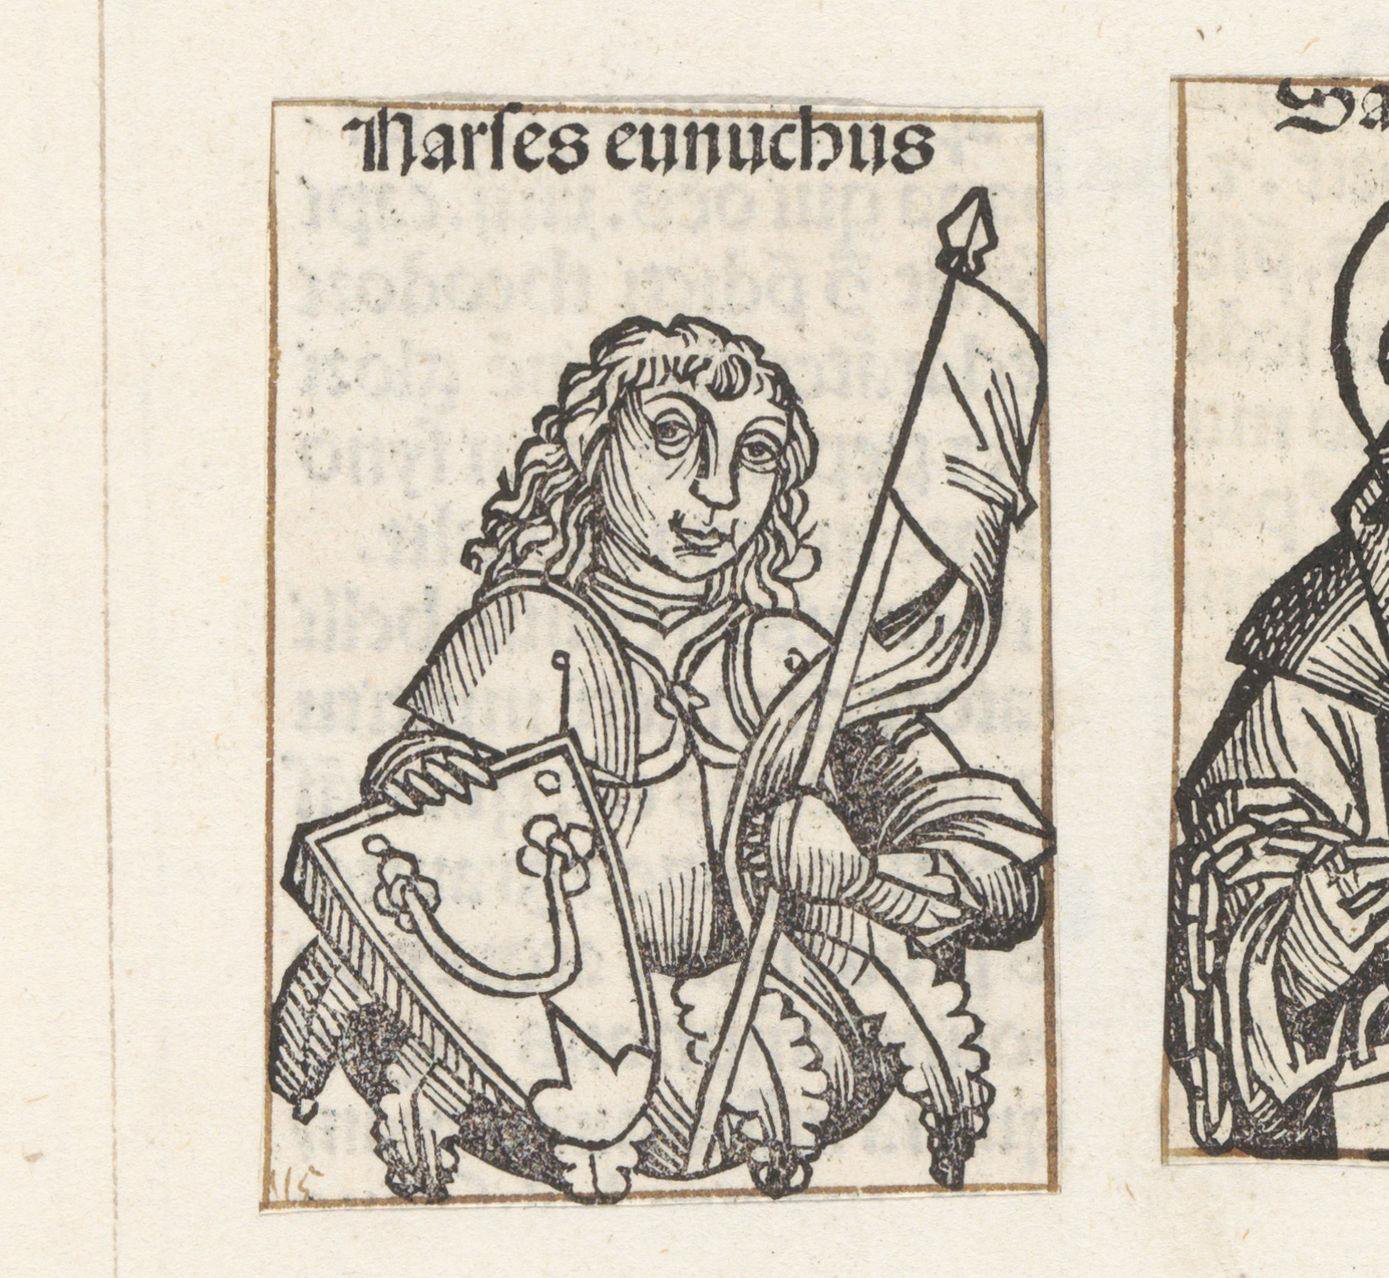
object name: album leaf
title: Generaal Narses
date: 1493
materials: paper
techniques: letterpress printing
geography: nuremberg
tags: male persons from classical history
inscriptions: inscription: ‘115’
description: De houtsnede wordt herhaaldelijk gebruikt als boekillustratie in de Liber Chronicarum (of Neurenbergkroniek) van Hartmann Schedel, verschenen in het Latijn en Duits in 1493. Zie de Latijnse uitgave, folio 145v.